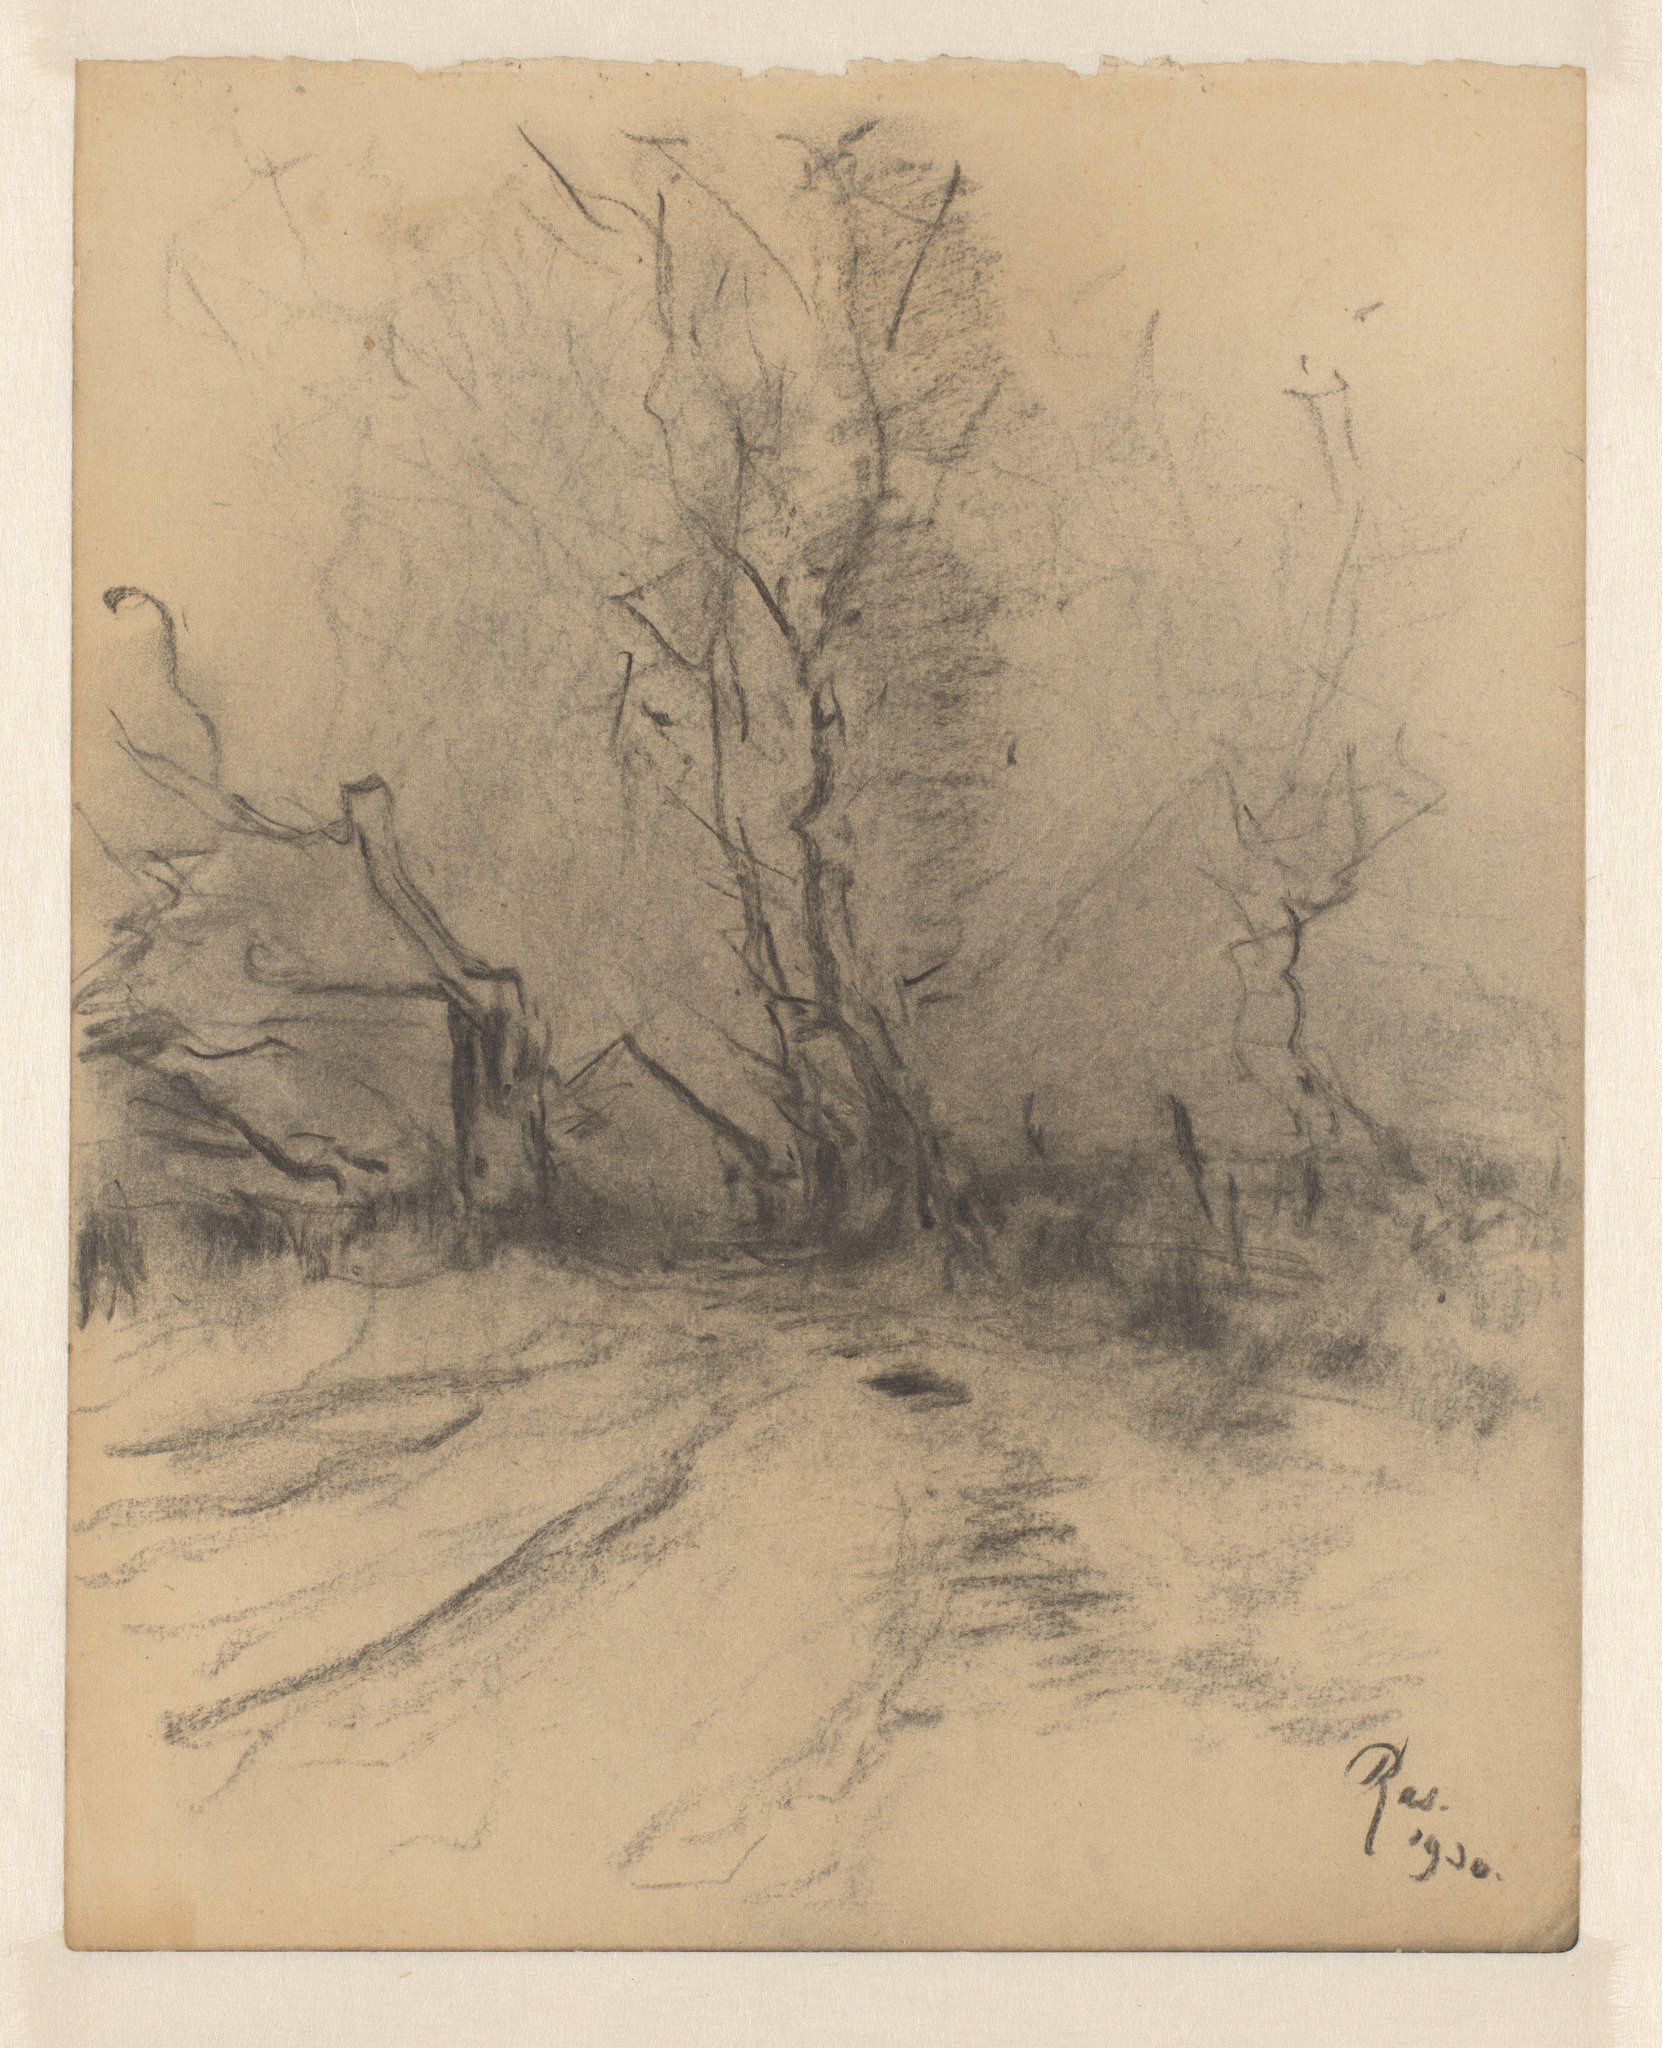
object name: drawing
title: Landweg met woningen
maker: pieter h.j.j. ras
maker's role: draughtsman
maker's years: 1857-1941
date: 1930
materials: chalk, paper